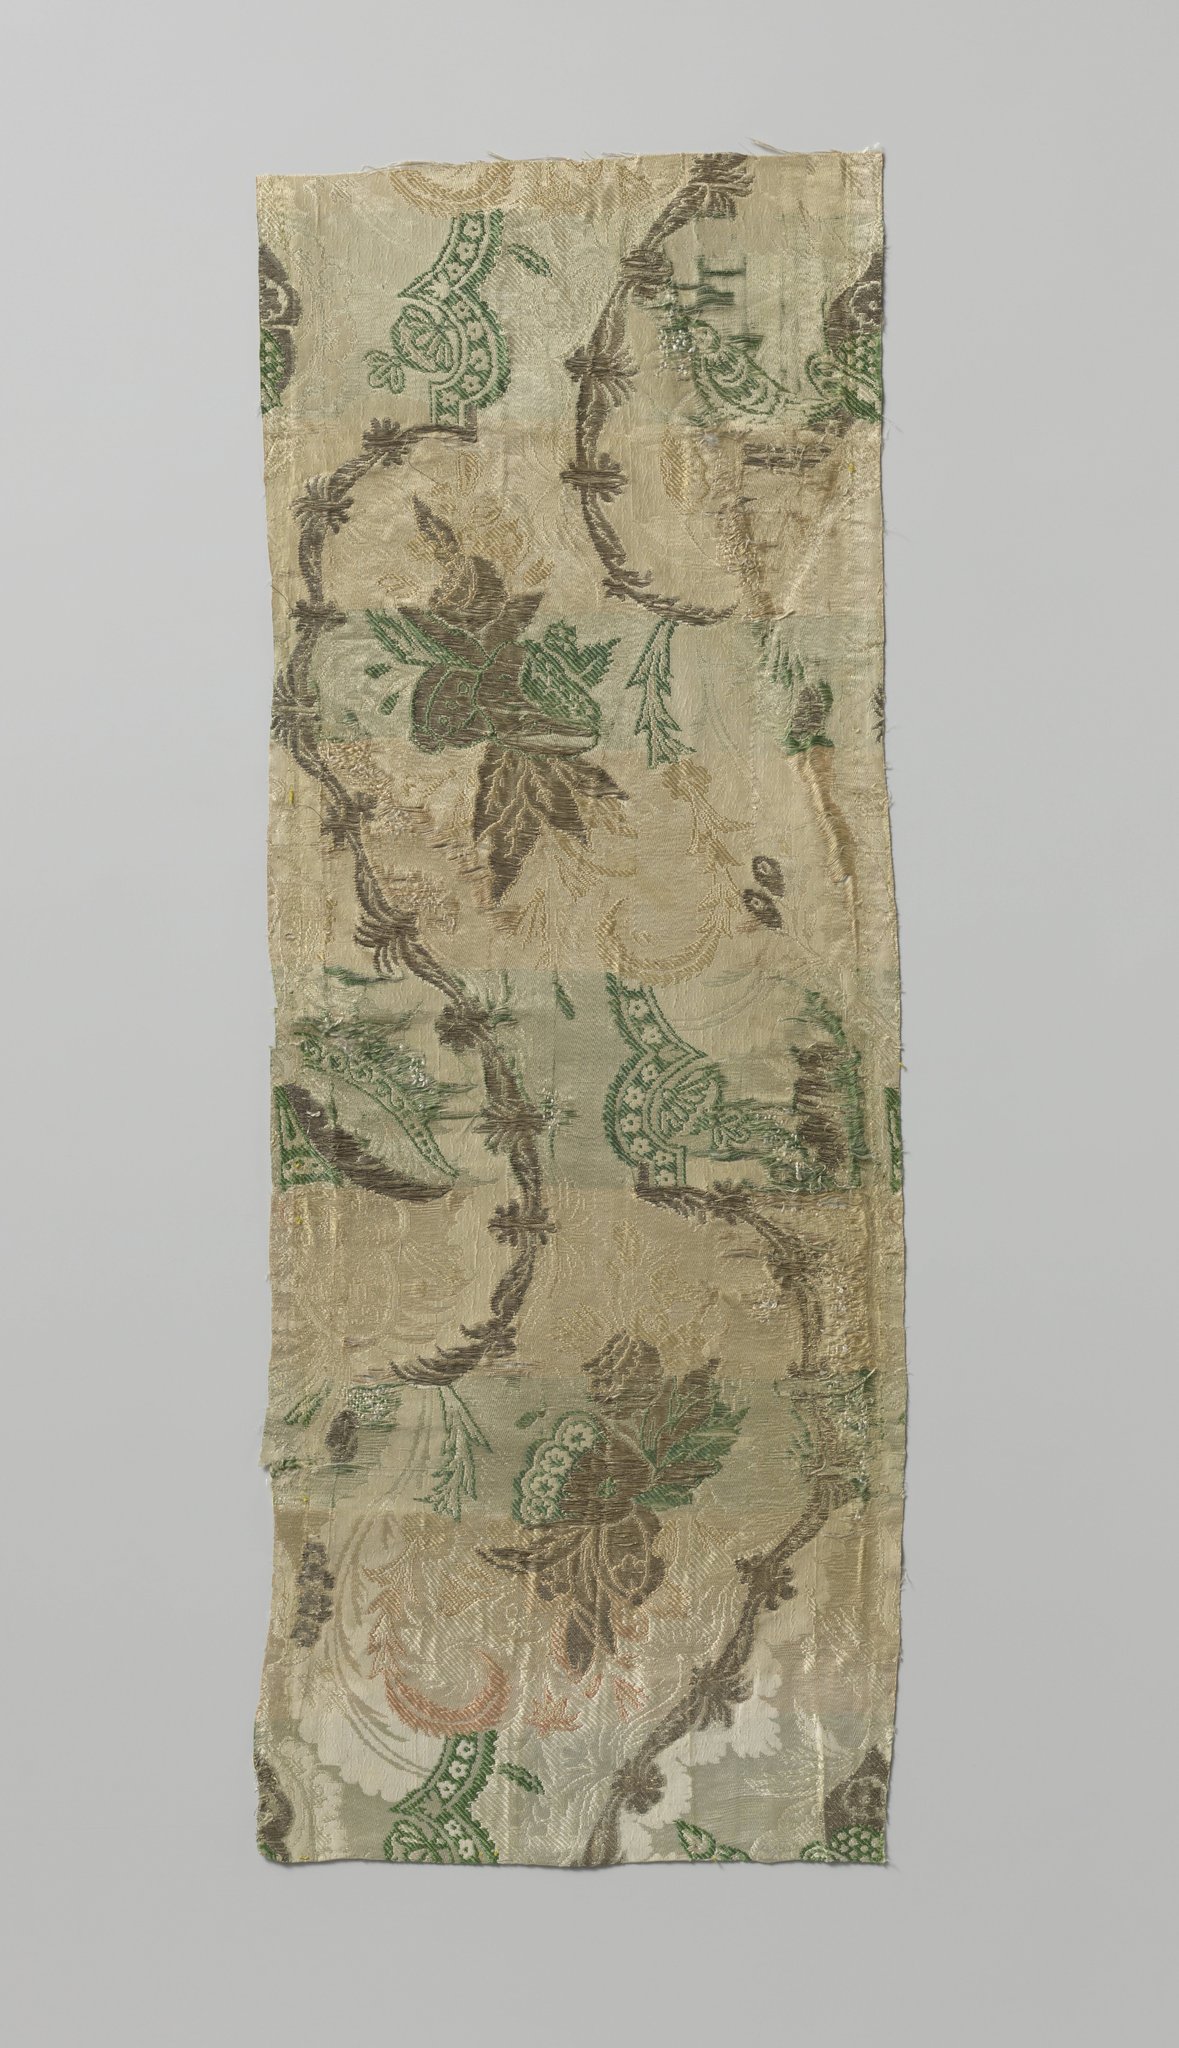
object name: fragment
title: Fragment zijdeweefsel; gedamasceerde lampas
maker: Anonymous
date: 1725-1750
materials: silk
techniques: brocade, damask, lampas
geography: lyon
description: Twee fragmenten zijdeweefsel met een patroon van bloemen van groene, bruine, gele en roze zijde en van goudraad. De kleur roze is tot crème verbleekt.